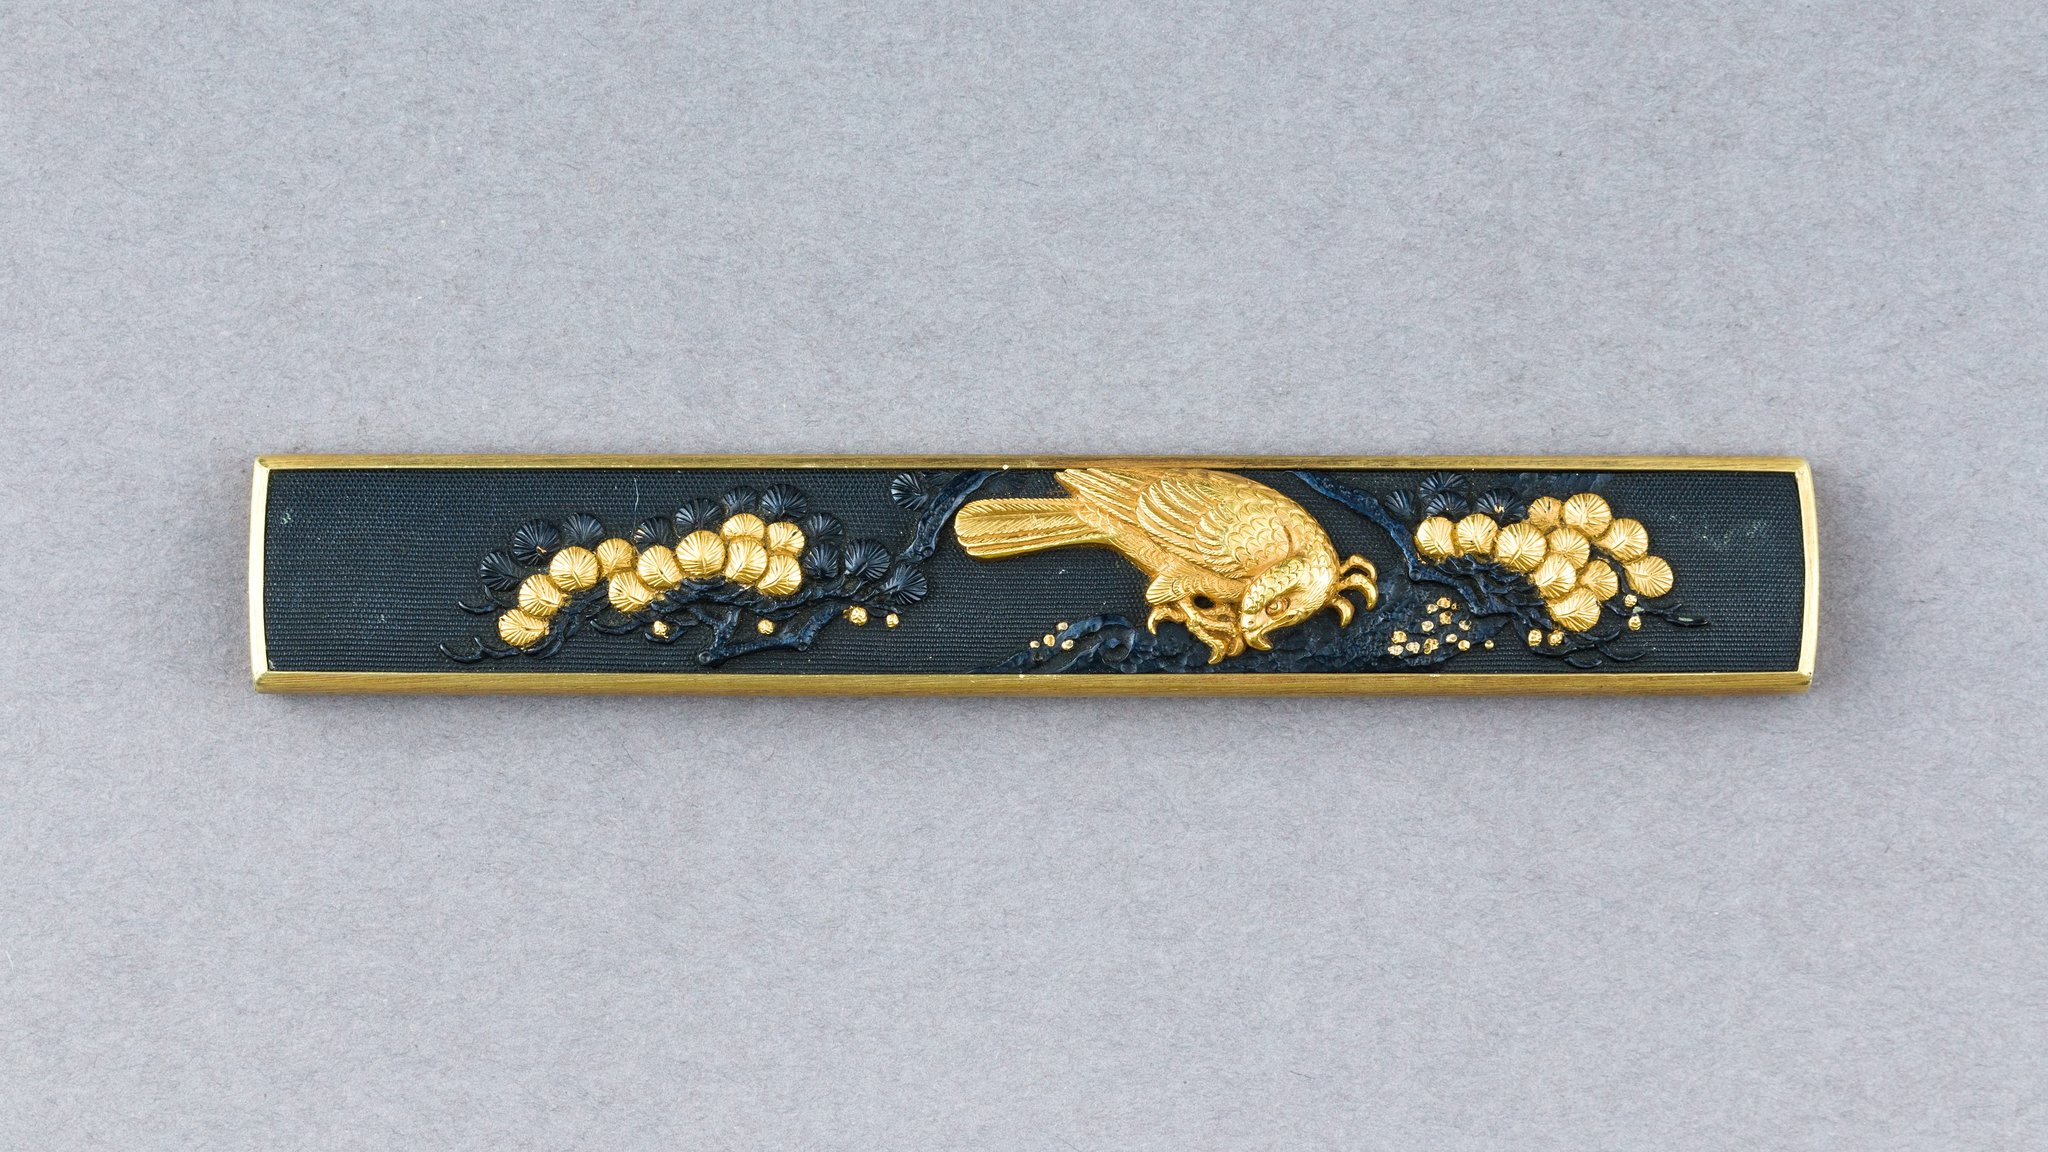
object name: knife handle kozuka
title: Knife Handle (Kozuka)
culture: japanese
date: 1615-1868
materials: gold alloy, gold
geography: japan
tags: birds